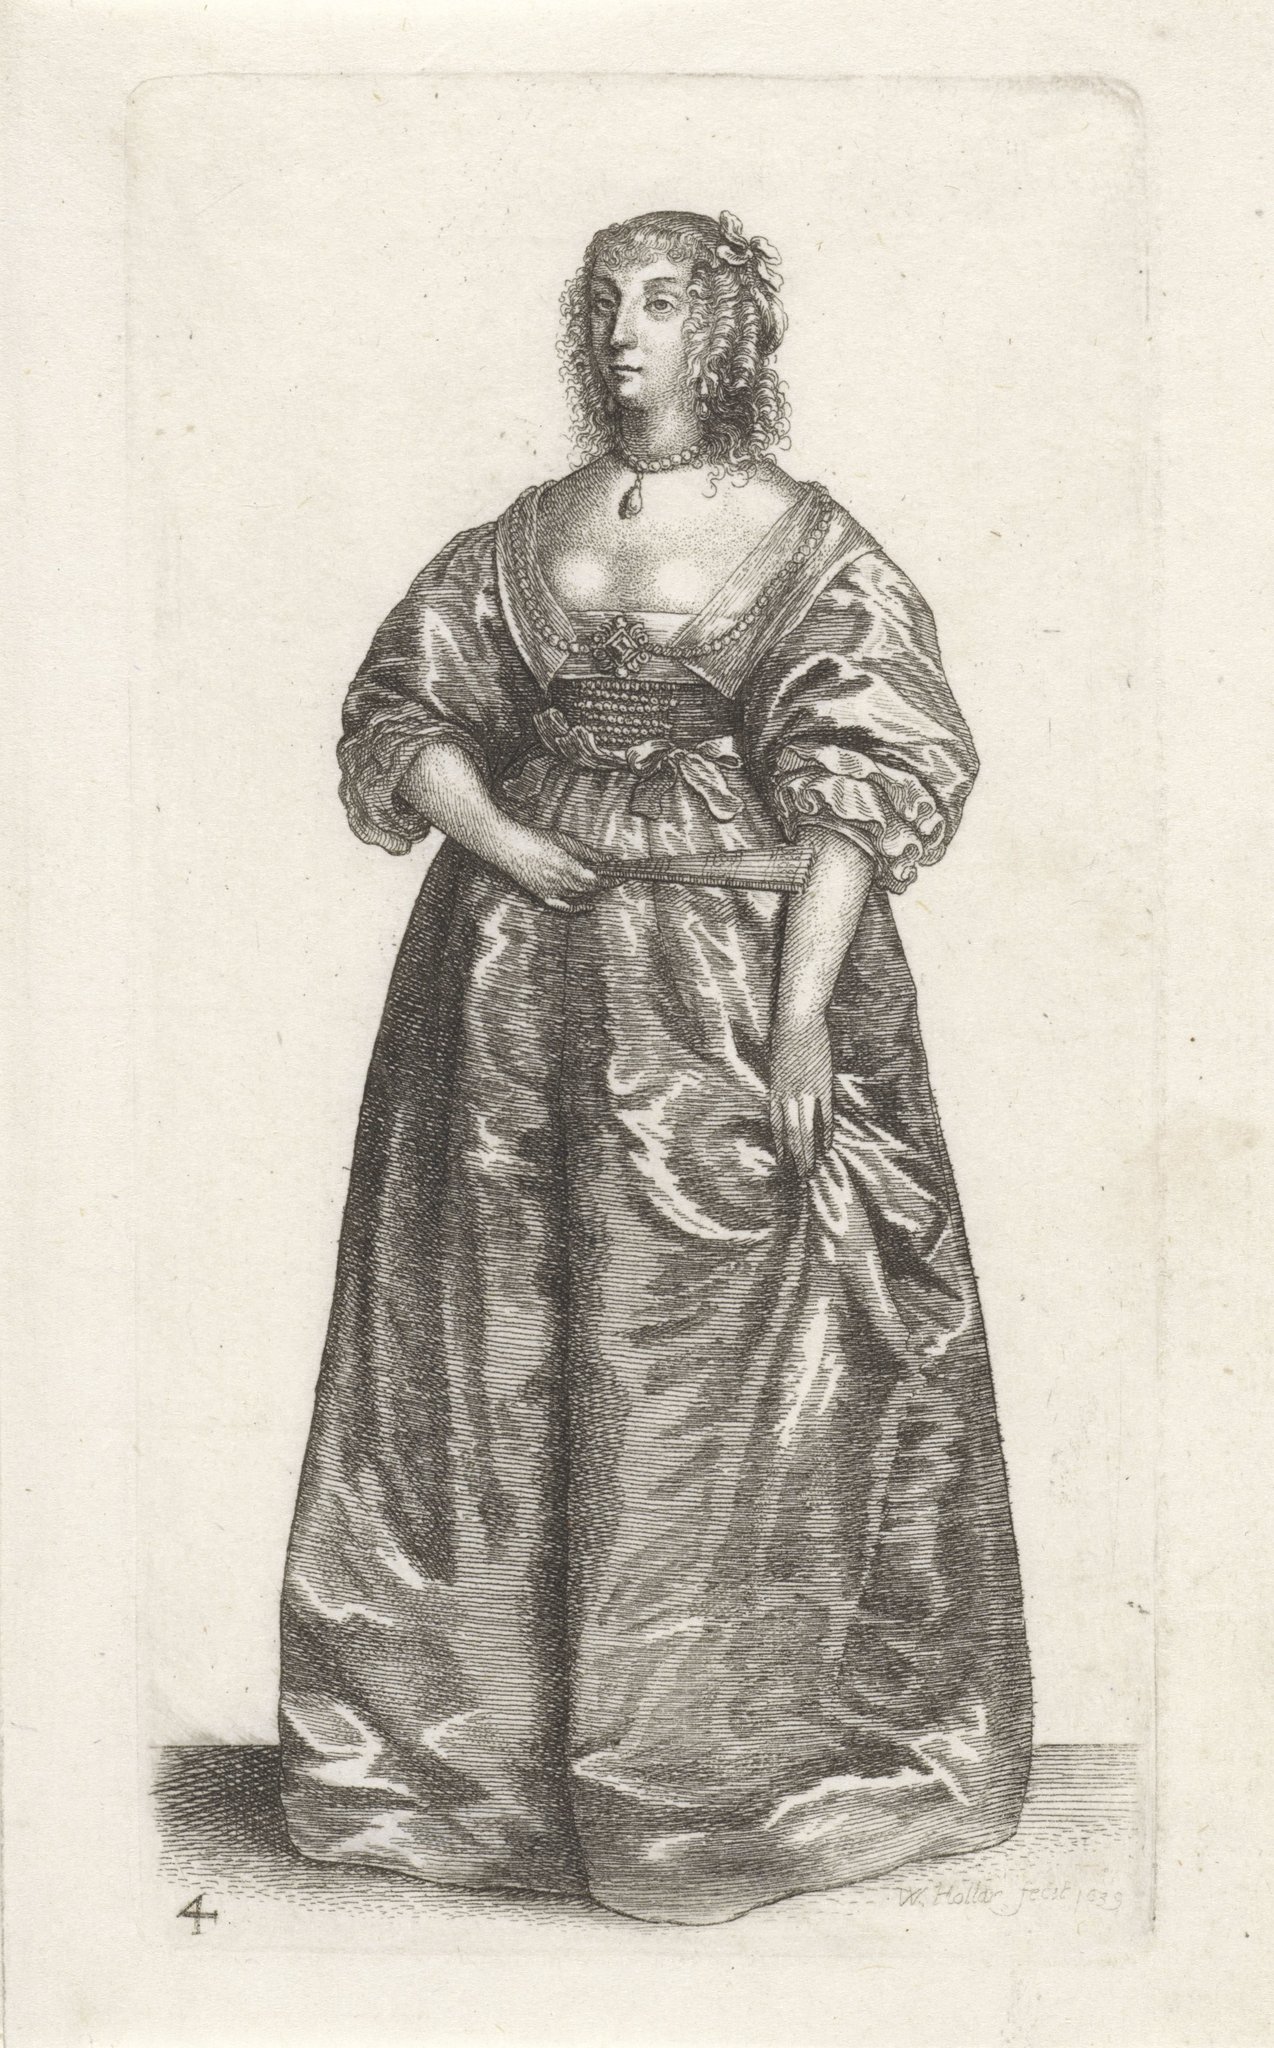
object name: costume print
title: Ornatus Muliebris Anglicanus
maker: wenceslaus hollar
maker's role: draughtsman, print maker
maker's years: 1607-1677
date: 1639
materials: paper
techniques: etching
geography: london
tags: europeans: englishmen (+ women), styles of hairdress - aa - ~ women, fashion plates, dress, gown (+ women's clothes), fan, pearl; pearl necklace (+ women's clothes), england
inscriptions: collector's mark: Lugt 654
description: Engelse vrouw van aanzien, in japon met hoge taille, lage rechte halsuitsnijding, wijde halflange mouwen en voetlange enigszins slepende rok. Het haar is strak naar achteren gekamd, behalve een rand van gefriseerd haar rondom het gezicht, dat een pony vormt op het voorhoofd en vanaf de zijkant tot aan de schouders afhangt. Links in het haar een strik. Rond de hals een parelketting met een druppelvormige parelhanger. Rond het décolleté een platte kraag waarover een lange parelketting met juweel dat in het midden op het lijf bevestigd is. De wijde mouwen zijn rond de elleboog gerimpeld en de mouwen van het hemd zijn hieronder zichtbaar. Op de verhoogde taille twee strikken. In de rechterhand een vouwwaaier en met de linkerhand wordt de rok opgenomen. No. 4 uit de serie Ornatus Muliebris Anglicanus.